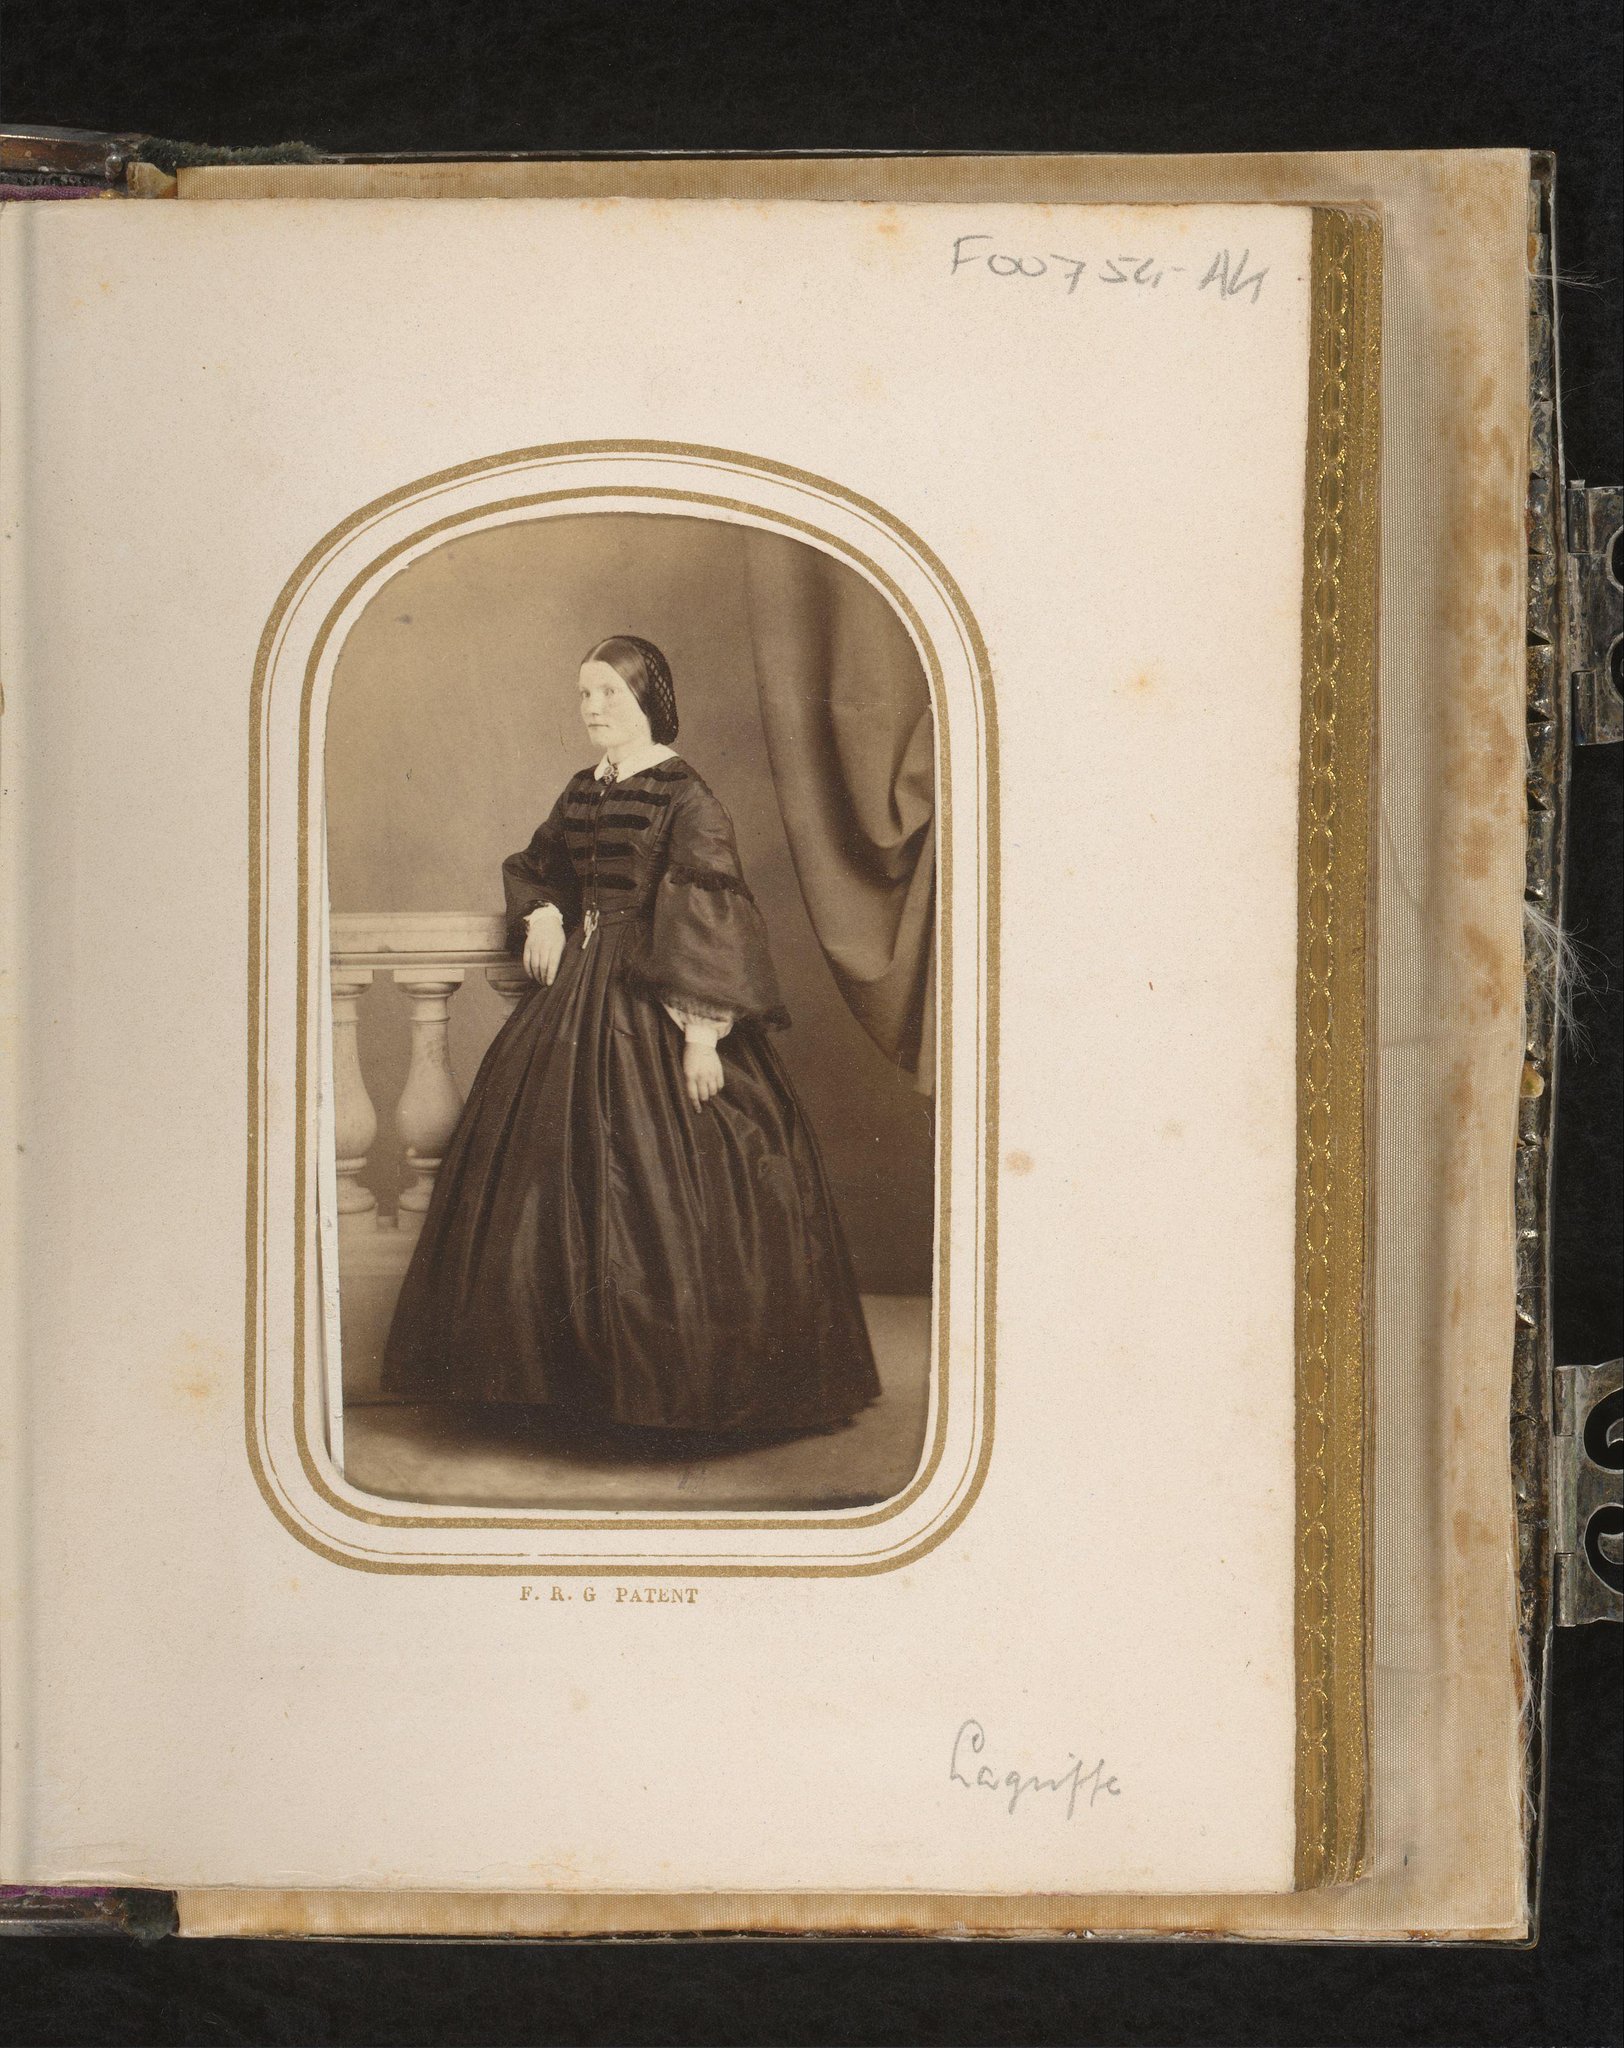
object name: album leaf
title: Portret van een staande vrouw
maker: jaques clément lagriffe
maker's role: fotograaf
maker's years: 1828-1899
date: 1855-1880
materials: cardboard, photographic support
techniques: albumen print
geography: paris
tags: historical persons - bb - woman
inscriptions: inscription: ‘Photographie/ Clément Lagriffe/ 203, Rue St. Honoré/ près St. Roch/ Paris’